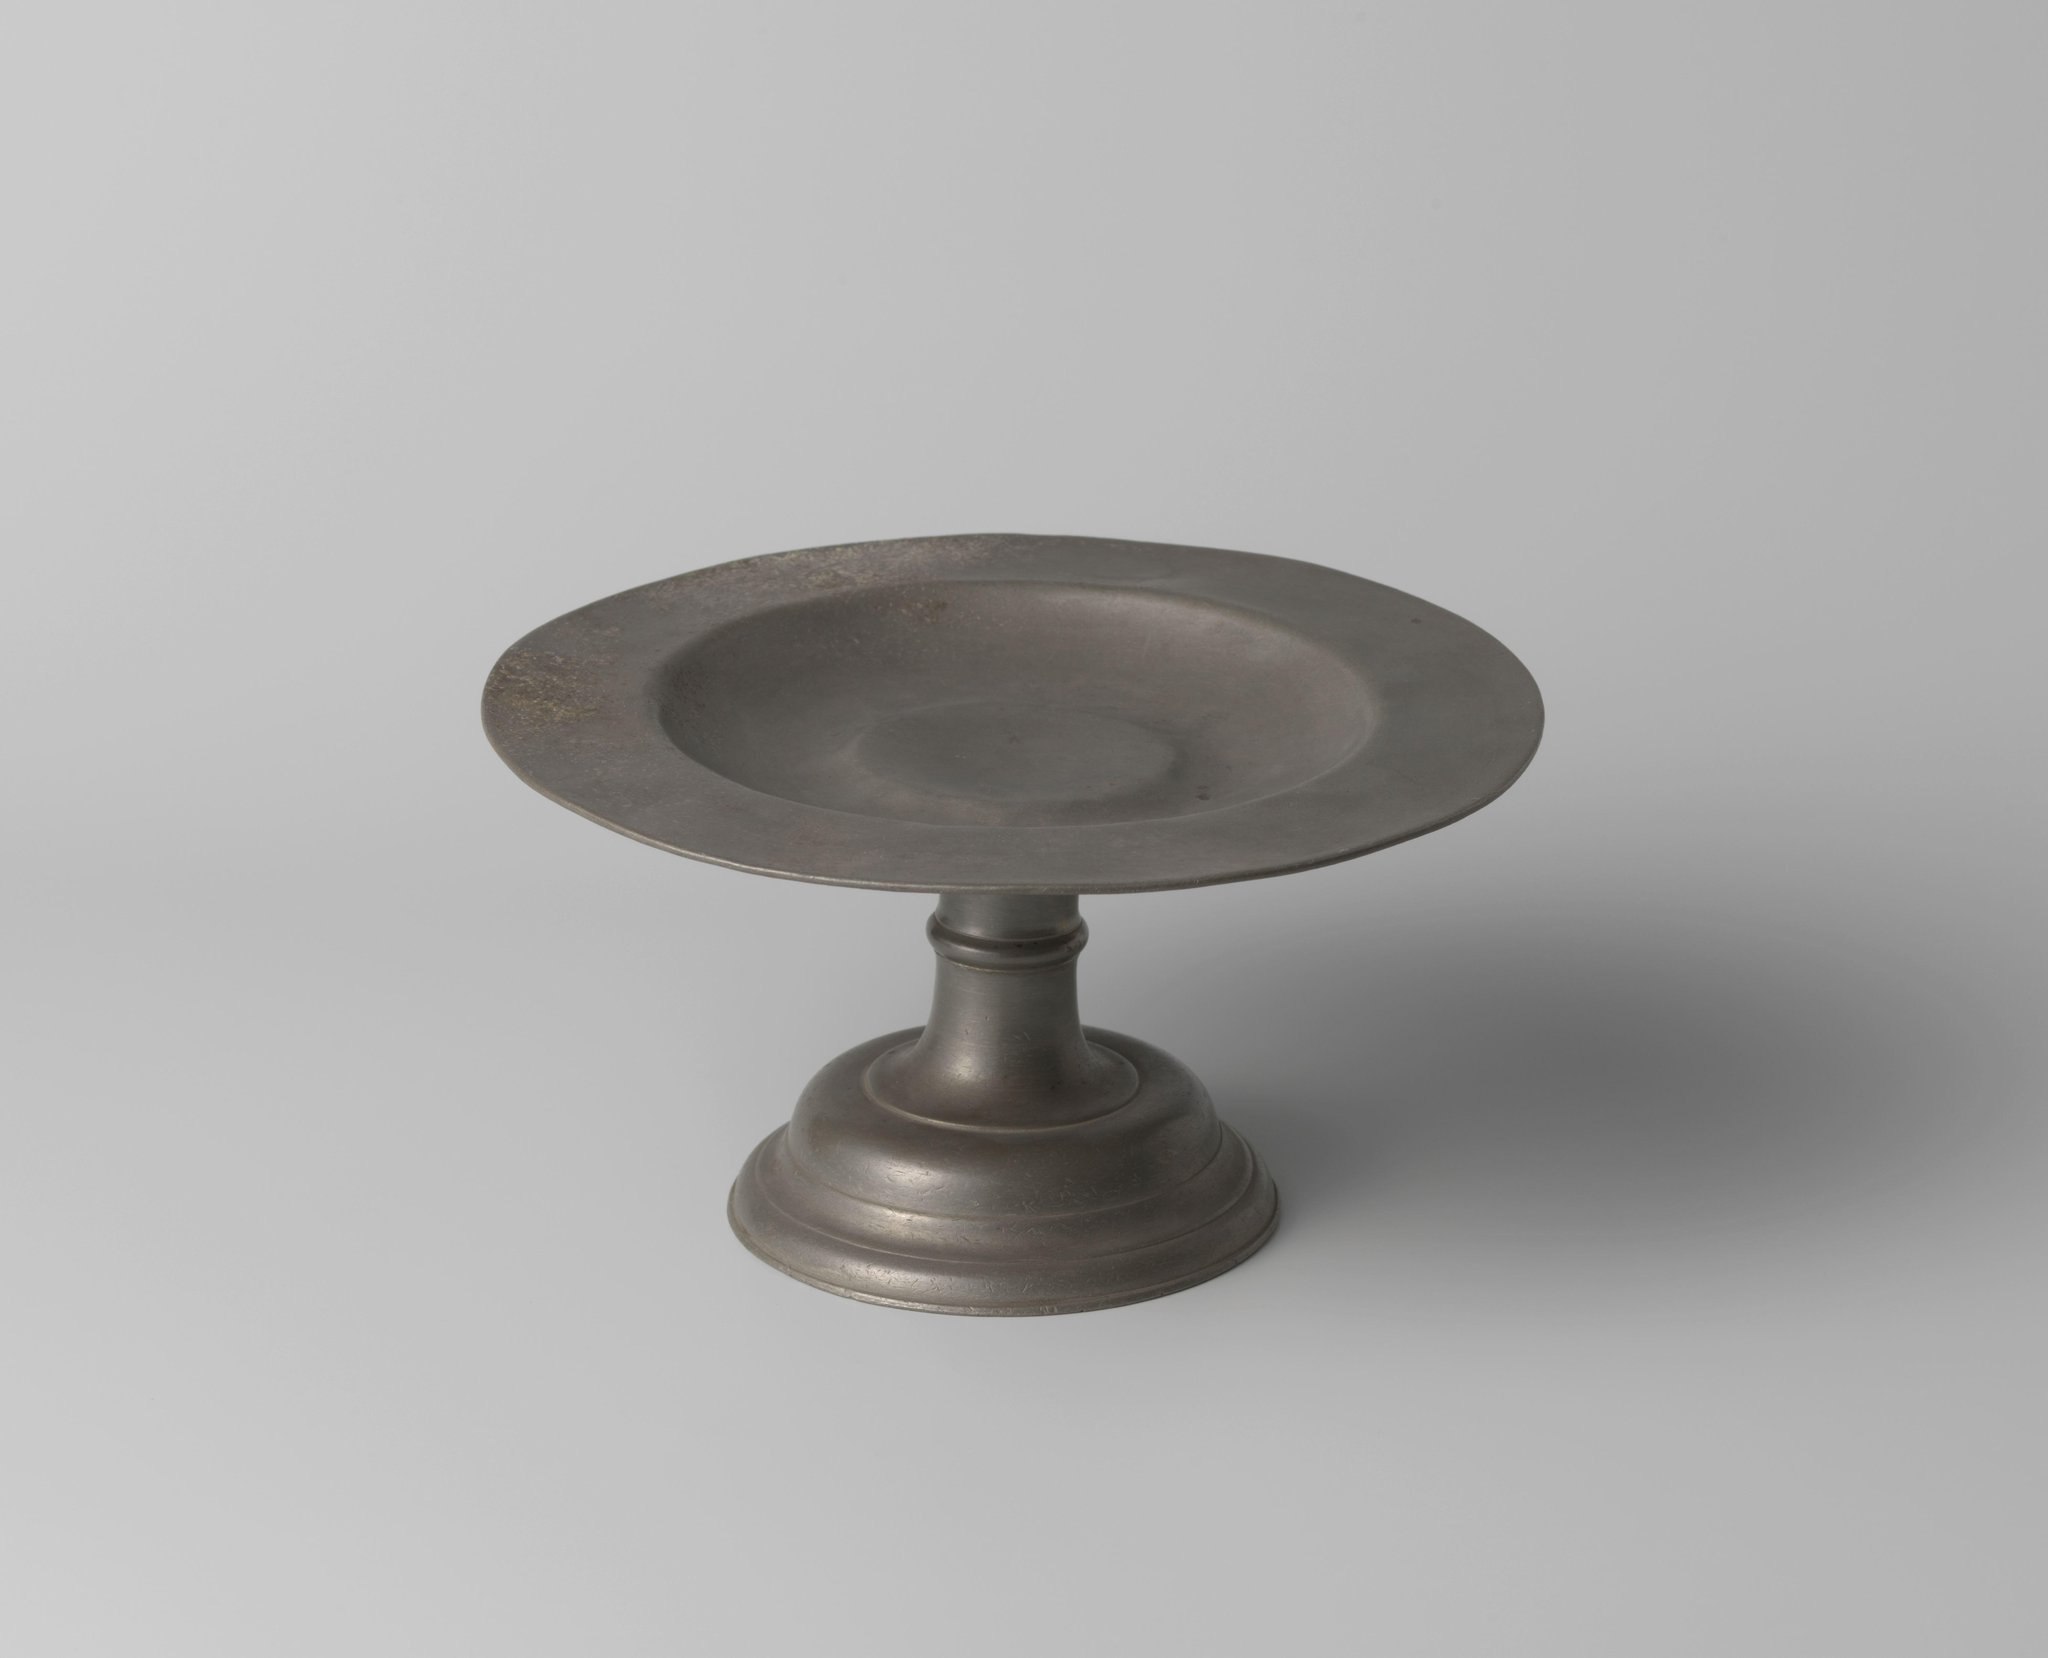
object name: dish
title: Schaal op voet, van tin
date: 1600-1699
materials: tin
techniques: casting, turning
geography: netherlands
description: Schaal op voet, van tin. De geprofileerde voet en stam dragen een ongedecoreerde, platte schaal. De vlakke spiegel gaat via een verder concave bodem over in een brede, platte rand.